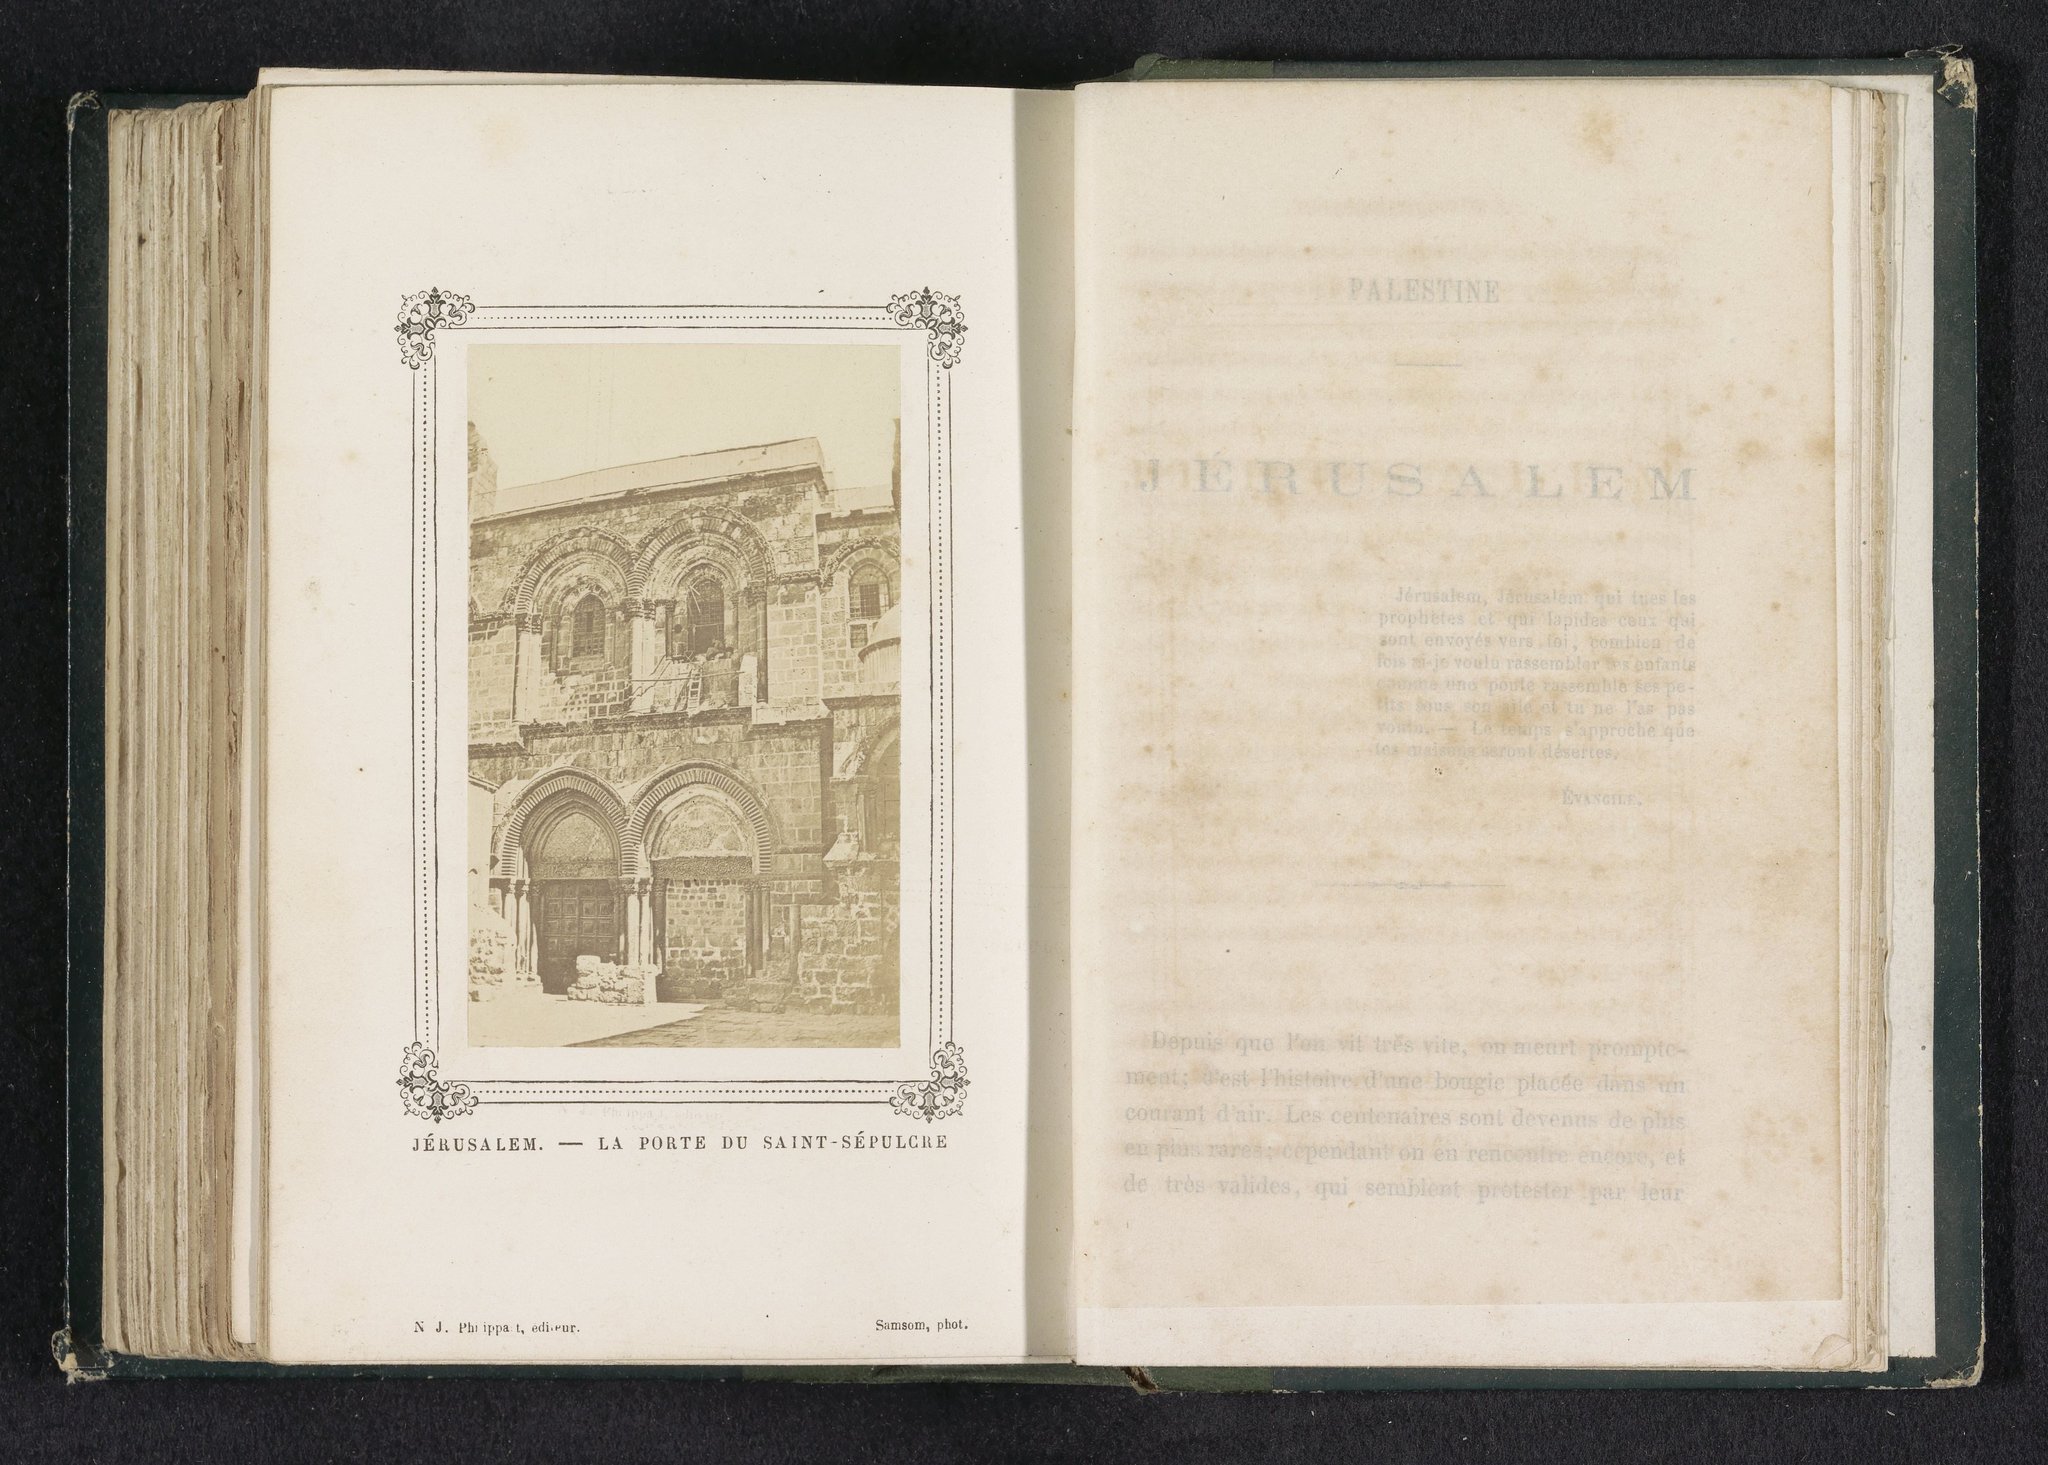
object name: page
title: Jérusalem-La porte du saint-sépulchre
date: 1853-1863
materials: photographic support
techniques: albumen print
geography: jerusalem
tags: parts of church exterior and annexes: portal, façade (of house or building)